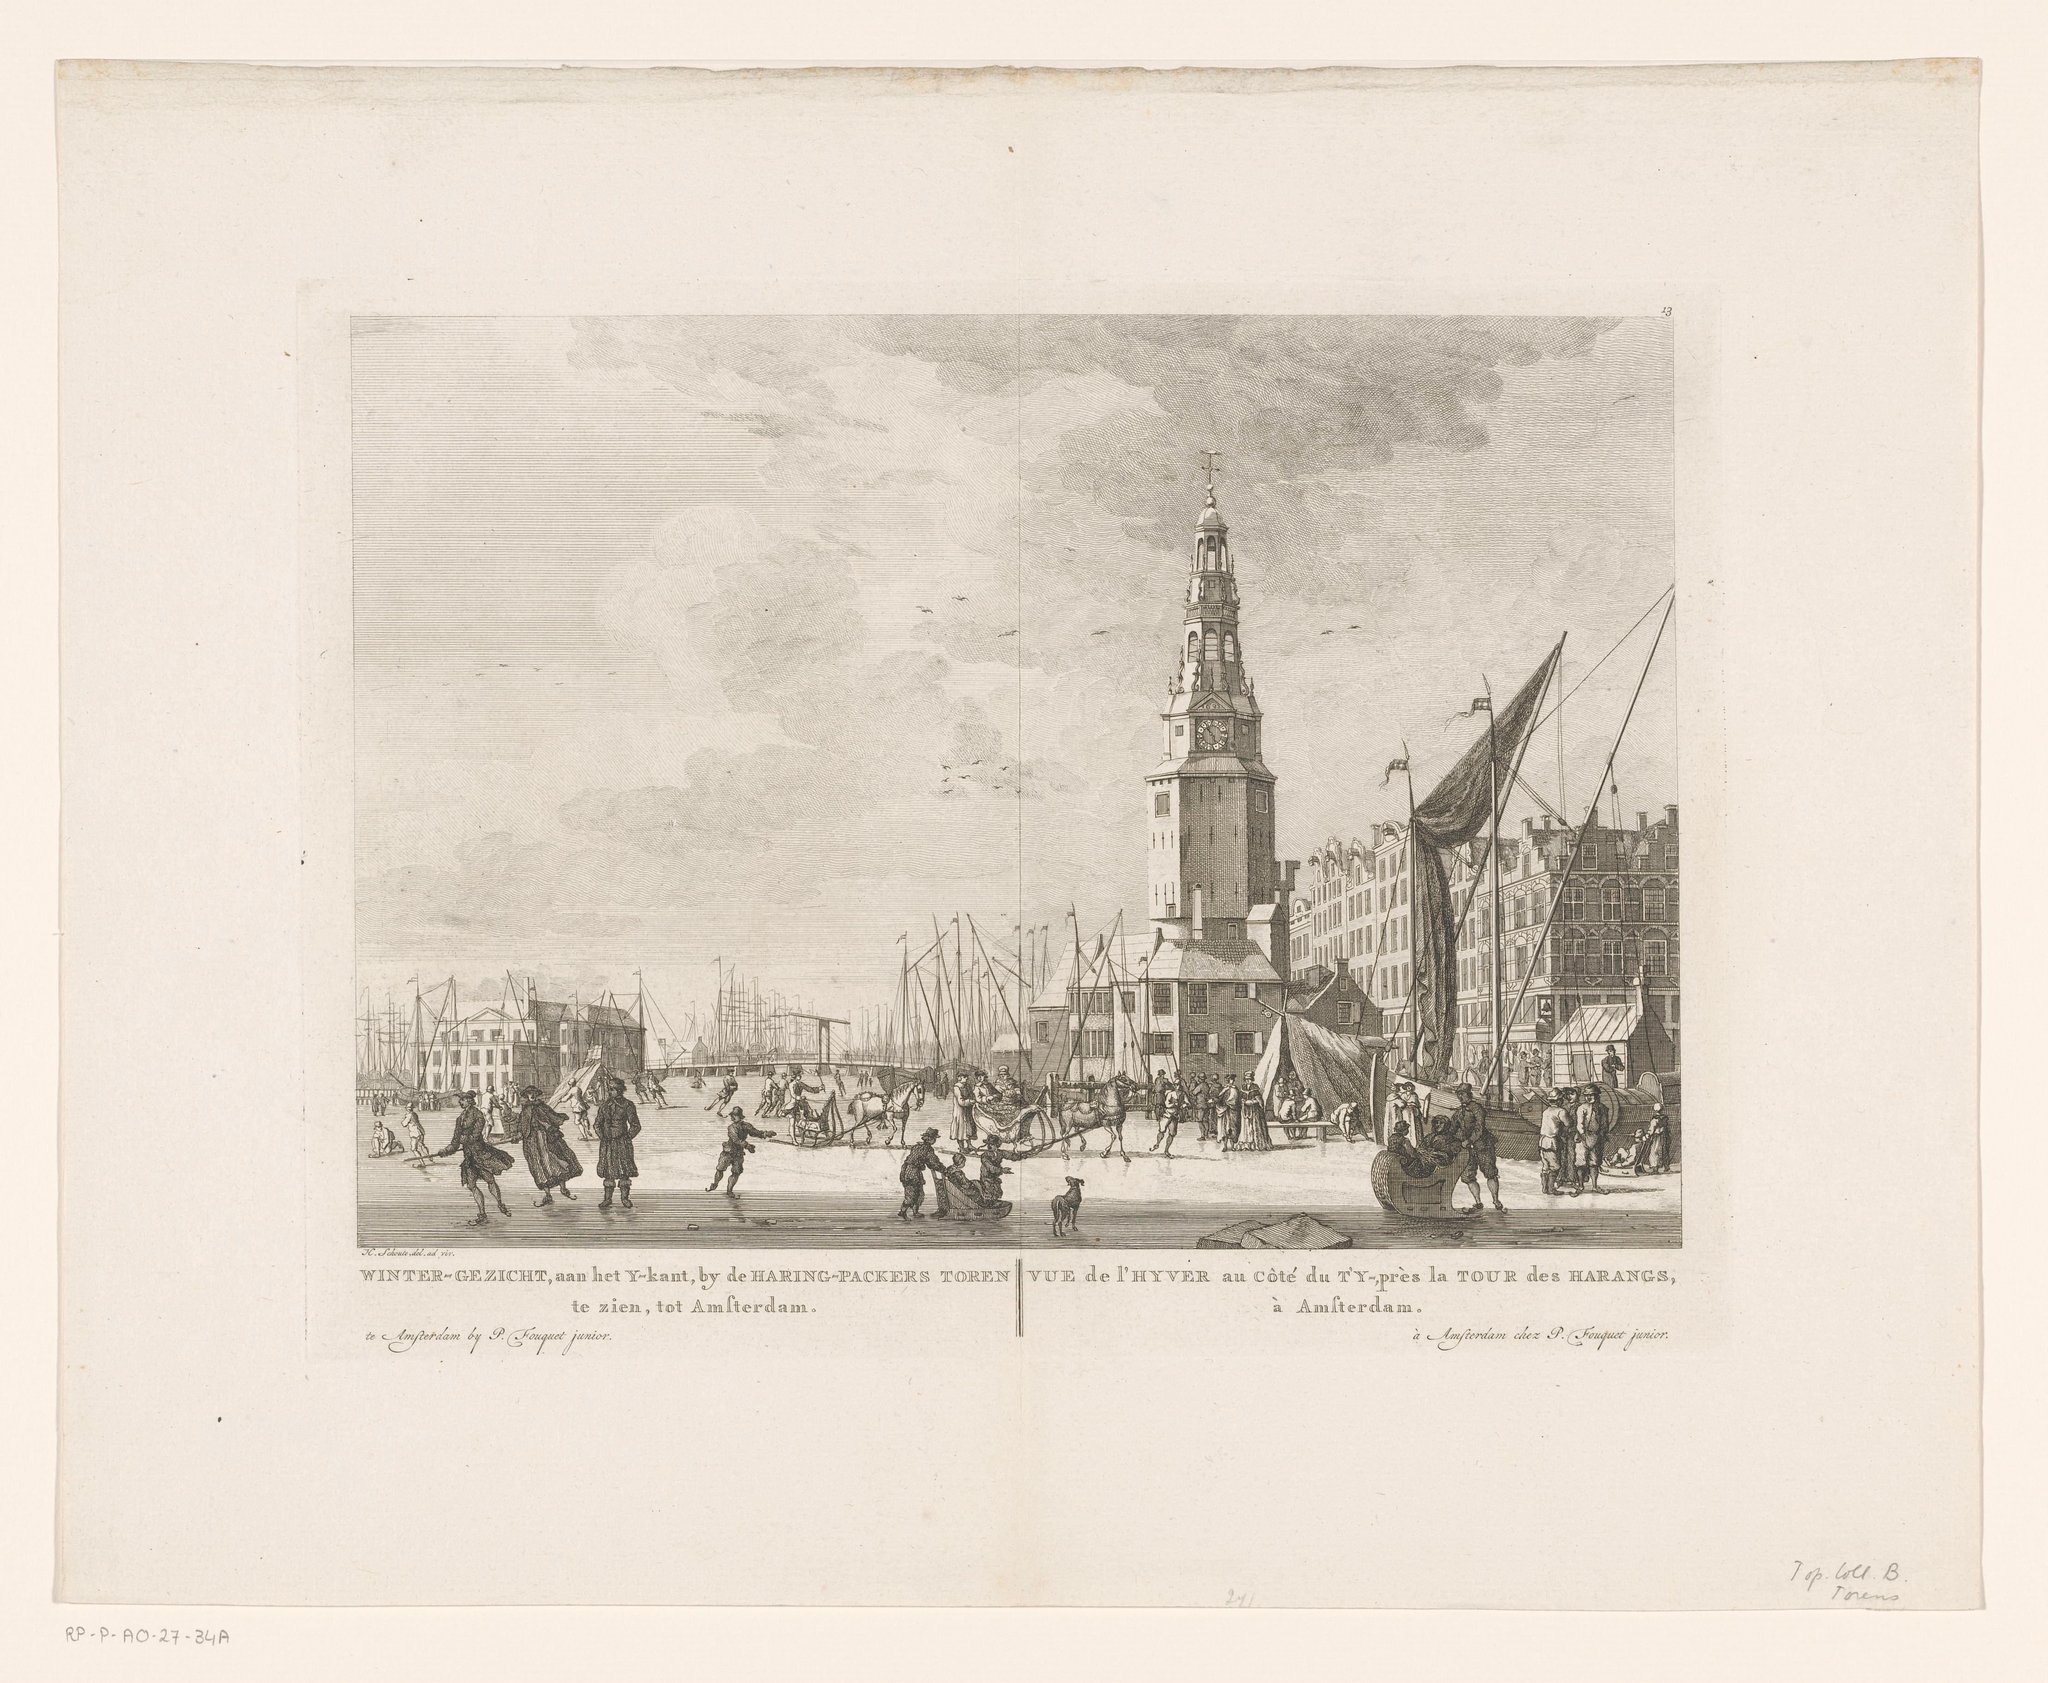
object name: print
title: Winter-gezicht, aan het Y-kant, by de Haring-Packers Toren te zien, tot Amsterdam / Vue de l'hyver au côté du t'Y-, près la Tour des Harangs, à Amsterdam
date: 1770-1783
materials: paper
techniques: engraving, etching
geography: amsterdam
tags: bridge in city across river, canal, etc. (+ city(-scape) with figures, staffage), tower, clock tower ~ monumental adornment, horse-sleigh, towers ~ fortified city, winter ~ human activities (the four seasons of the year), skates (winter sports), sledge, sleigh (winter sports), canals, waters (in city) (+ city(-scape) with figures, staffage)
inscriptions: collector's mark: Lugt 2228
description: Deze prent is ook gebruikt in de zogenaamde Atlas van Fouquet.* Pierre Fouquet gaf vanaf 1760 stadsgezichten van Amsterdam - naar tekeningen van verschillende kunstenaars, gemaakt door verschillende prentmakers - uit. Deze prenten werden aanvankelijk los of in series verkocht. Zoals toen gebruikelijk kon de koper de prenten zelf laten inbinden. Hiertoe gaf Fouquet tussen 1778 en 1783 een titelblad, plattegrond en inhoudsopgave van de tot dusver 100 uitgegeven prenten uit (1). Gezien de inhoud afhankelijk was van wat de koper had verzameld verschilt de inhoud van de verschillende bewaarde Fouquetatlassen onder deze titel sterk. Ook zijn er exemplaren bekend waar tevens andere prenten aan zijn toegevoegd. Omdat er behoefte bleek aan uitleg bij de platen werd in 1783 een nieuwe versie van de atlas uitgegeven, aangevuld met tekst en twee prenten. De aangegeven volgorde veranderde maar de platen van de al eerder uitgegeven prenten bleven ongewijzigd. Deze uitgave werd in opdracht van Fouquet gedrukt bij Daniël Jean Changuion en Petrus den Hengst (2). Een tiental platen werd bijgewerkt en verscheen, met nieuw impressum, in het vervolg van Wagenaars geschiedenis van Amsterdam, uitgeven door Petrus Conradi en Folkert van der Plaats (3). Een aantal jaar na het overlijden van Fouquet kwam Evert Maaskamp met een nieuwe uitgave van de atlas, met verbeterde tekst en toevoeging van twee prenten. Op alle platen verwijderde hij het oude en liet hij zijn eigen impressum zetten (4). De huidige staat van de prent komt voor in exemplaren van de onder (1) en (2) genoemde werken. * Onder de Atlas van Fouquet of Fouquetatlas verstaan we de hieronder vermelde publicaties (1), (2) en (4). (1). Afbeeldingen van de wyd-vermaarde koopstad Amsterdam benevens des zelvs voornaamste gebouwen en gezigten alle naar het leeven getekend / Receuil des edifices les plus considerables et des plus belles vues, de la fameuse ville d'Amsterdam, dessinées d'après nature. Amsterdam: Pierre Fouquet, 1778-1783. (2). Nieuwe atlas, van de voornaamste gebouwen en gezigten der stad Amsterdam, met derzelver beknopte beschryvingen. 2 delen. Amsterdam: Daniël Jean Changuion en Petrus den Hengst [in opdracht van Pierre Fouquet], 1783. (3). Stijl, Simon. Amsterdam, in zyne geschiedenissen, voorregten, koophandel, gebouwen, kerkenstaat, schoolen, schutterye, gilden en regeeringe, beschreeven. Om te dienen ten vervolge op het werk van Jan Wagenaar (…). 10 delen. Amsterdam en Harlingen: Petrus Conradi en Folkert van der Plaats, 1788-1801. (4). Nieuwe atlas, van de voornaamste gebouwen en gezigten der stad Amsterdam. Met derzelver beknopte beschryvingen. Amsterdam: Evert Maaskamp, 1805. * Het aantal vermelde staten is gebaseerd op het aantal gevonden staten. Mogelijk zijn er meer staten van deze prent. Zie RP-P-1921-492 voor eerste bekende staat.